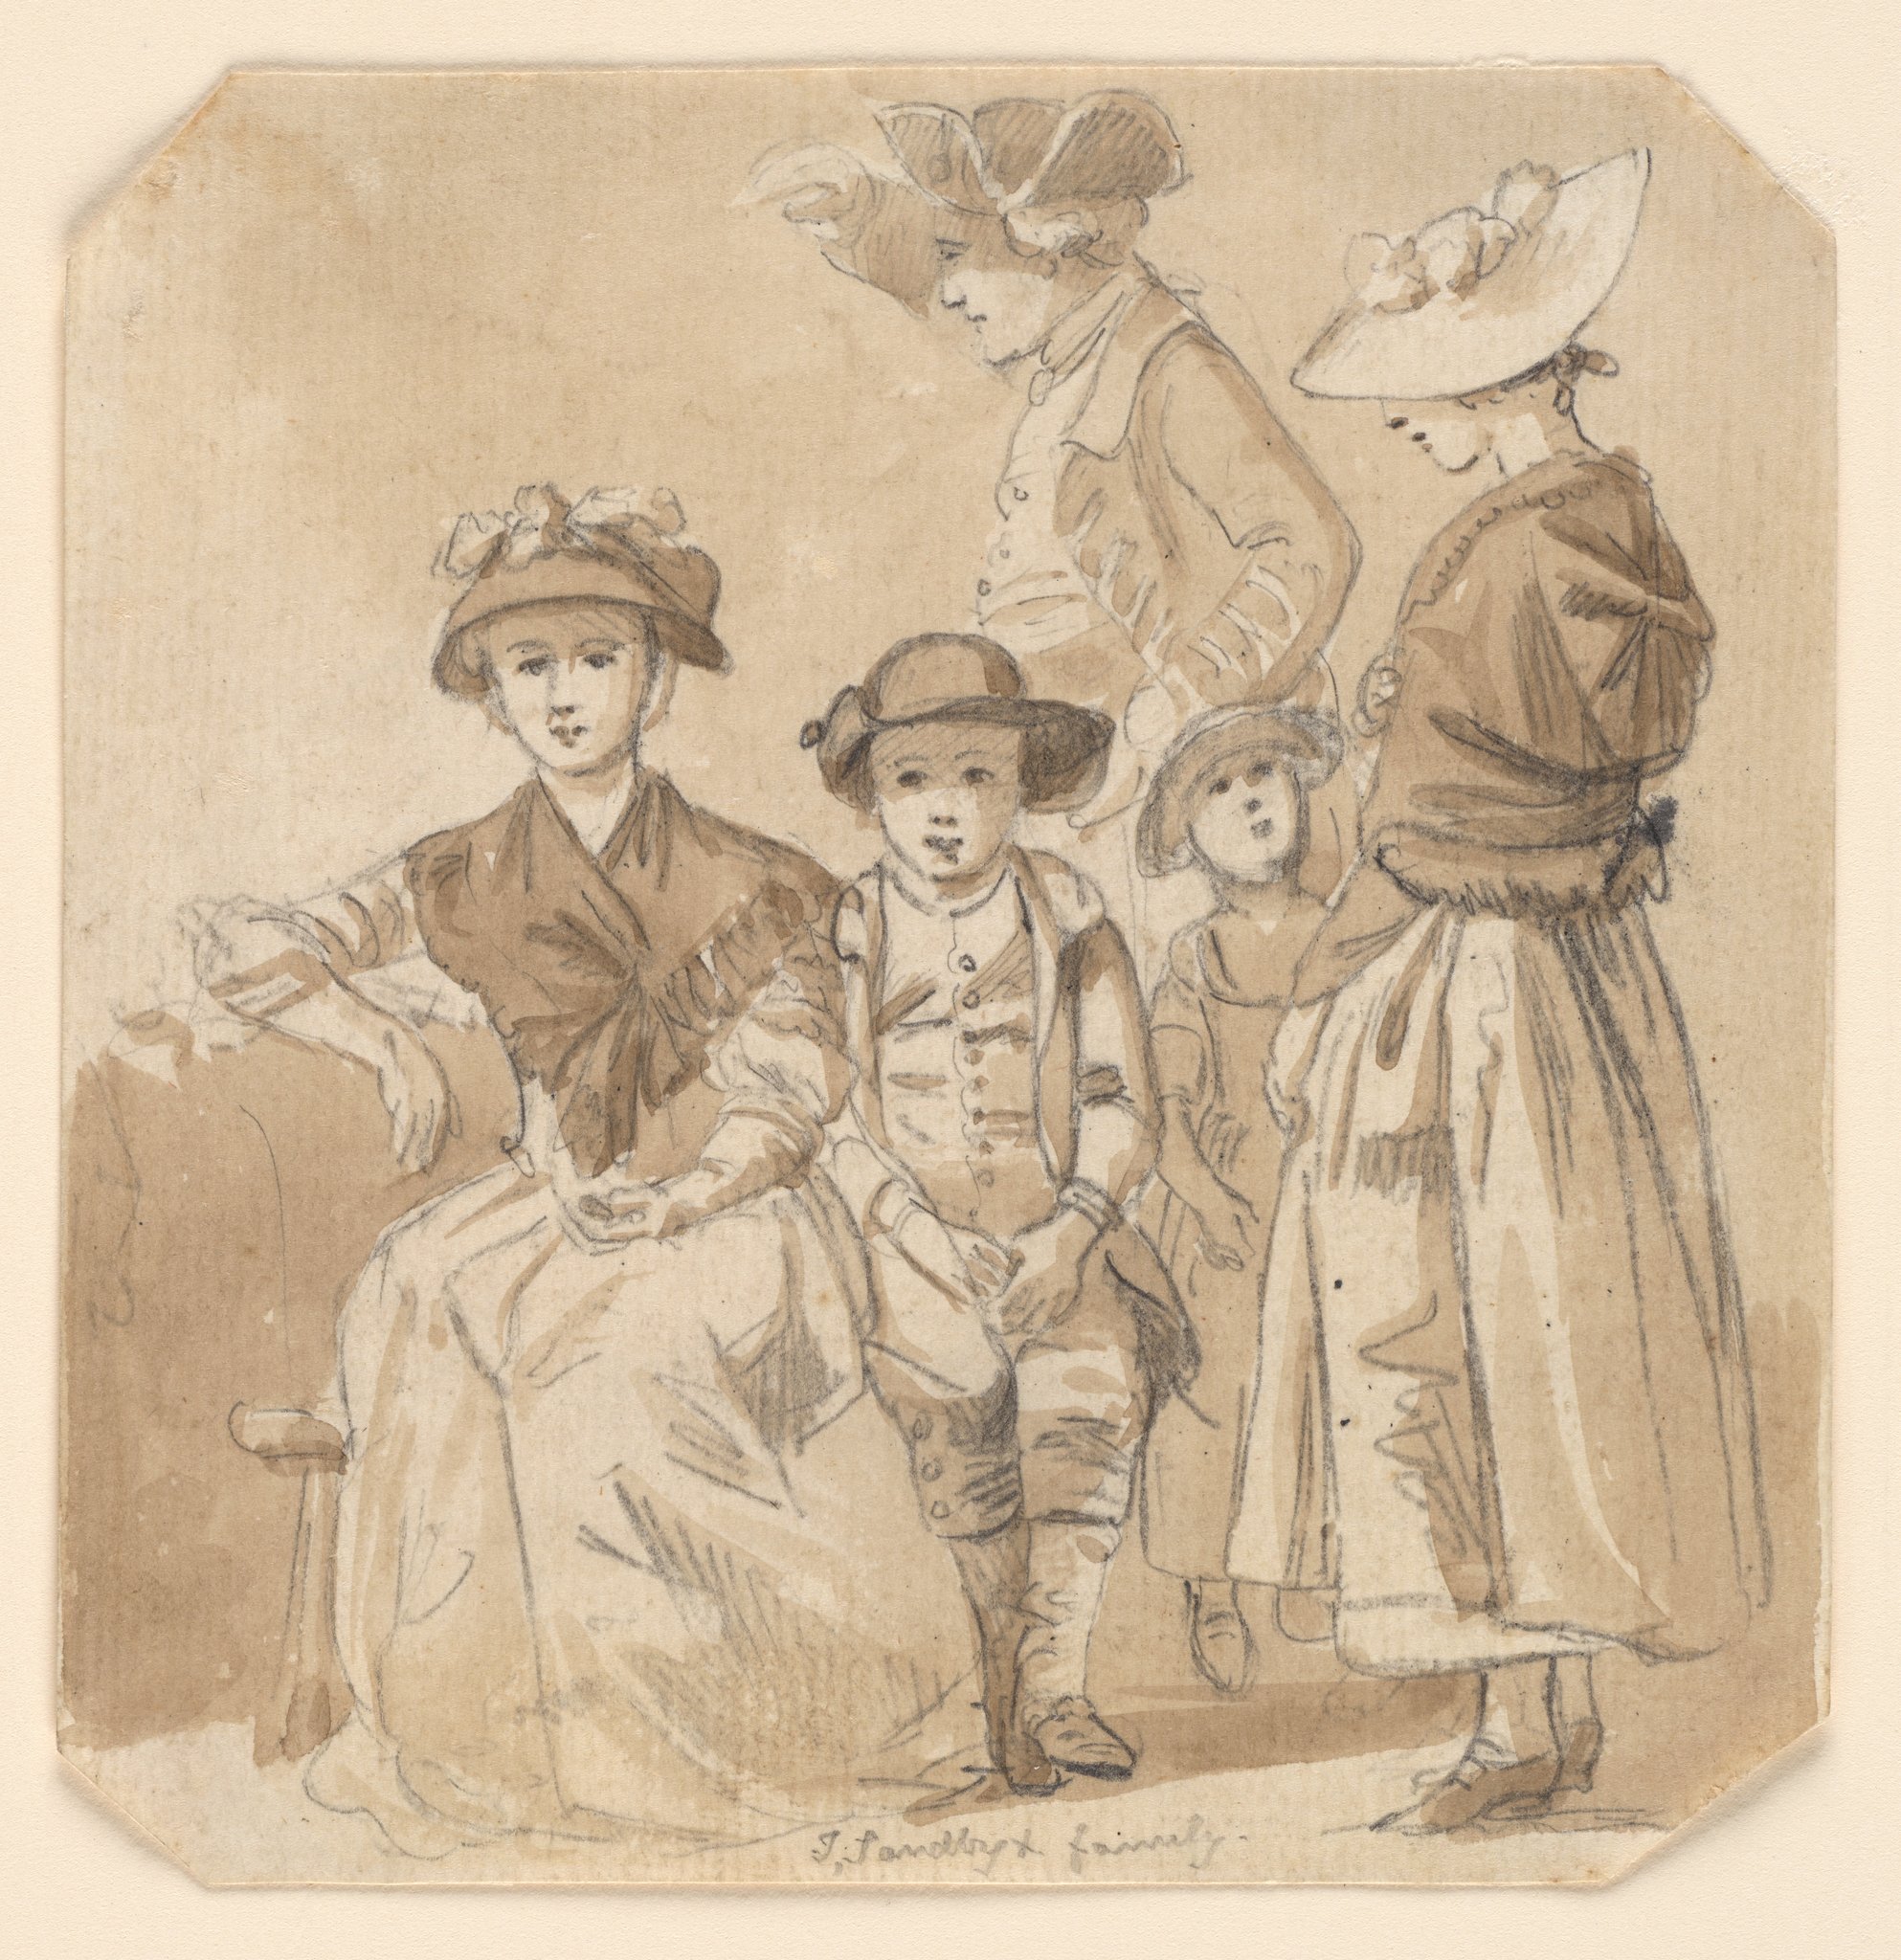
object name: drawing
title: Thomas Sandby and His Family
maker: paul sandby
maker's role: artist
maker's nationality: british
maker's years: 1731-1809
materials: ink, pencil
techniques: brush, wash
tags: boys,girls,men,women,family